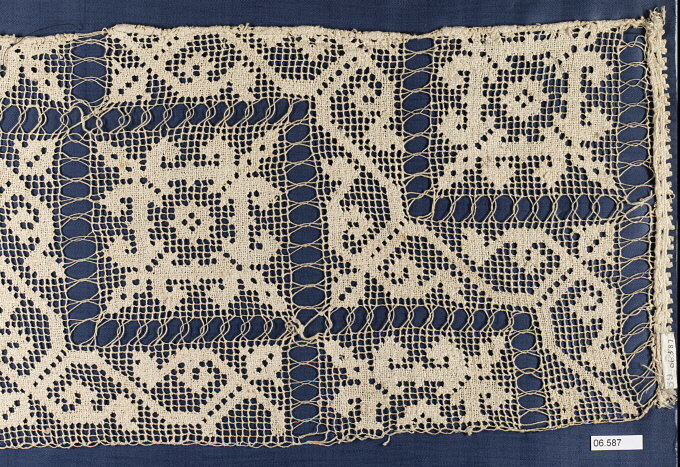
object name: fragment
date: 1601-1700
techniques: embroidery